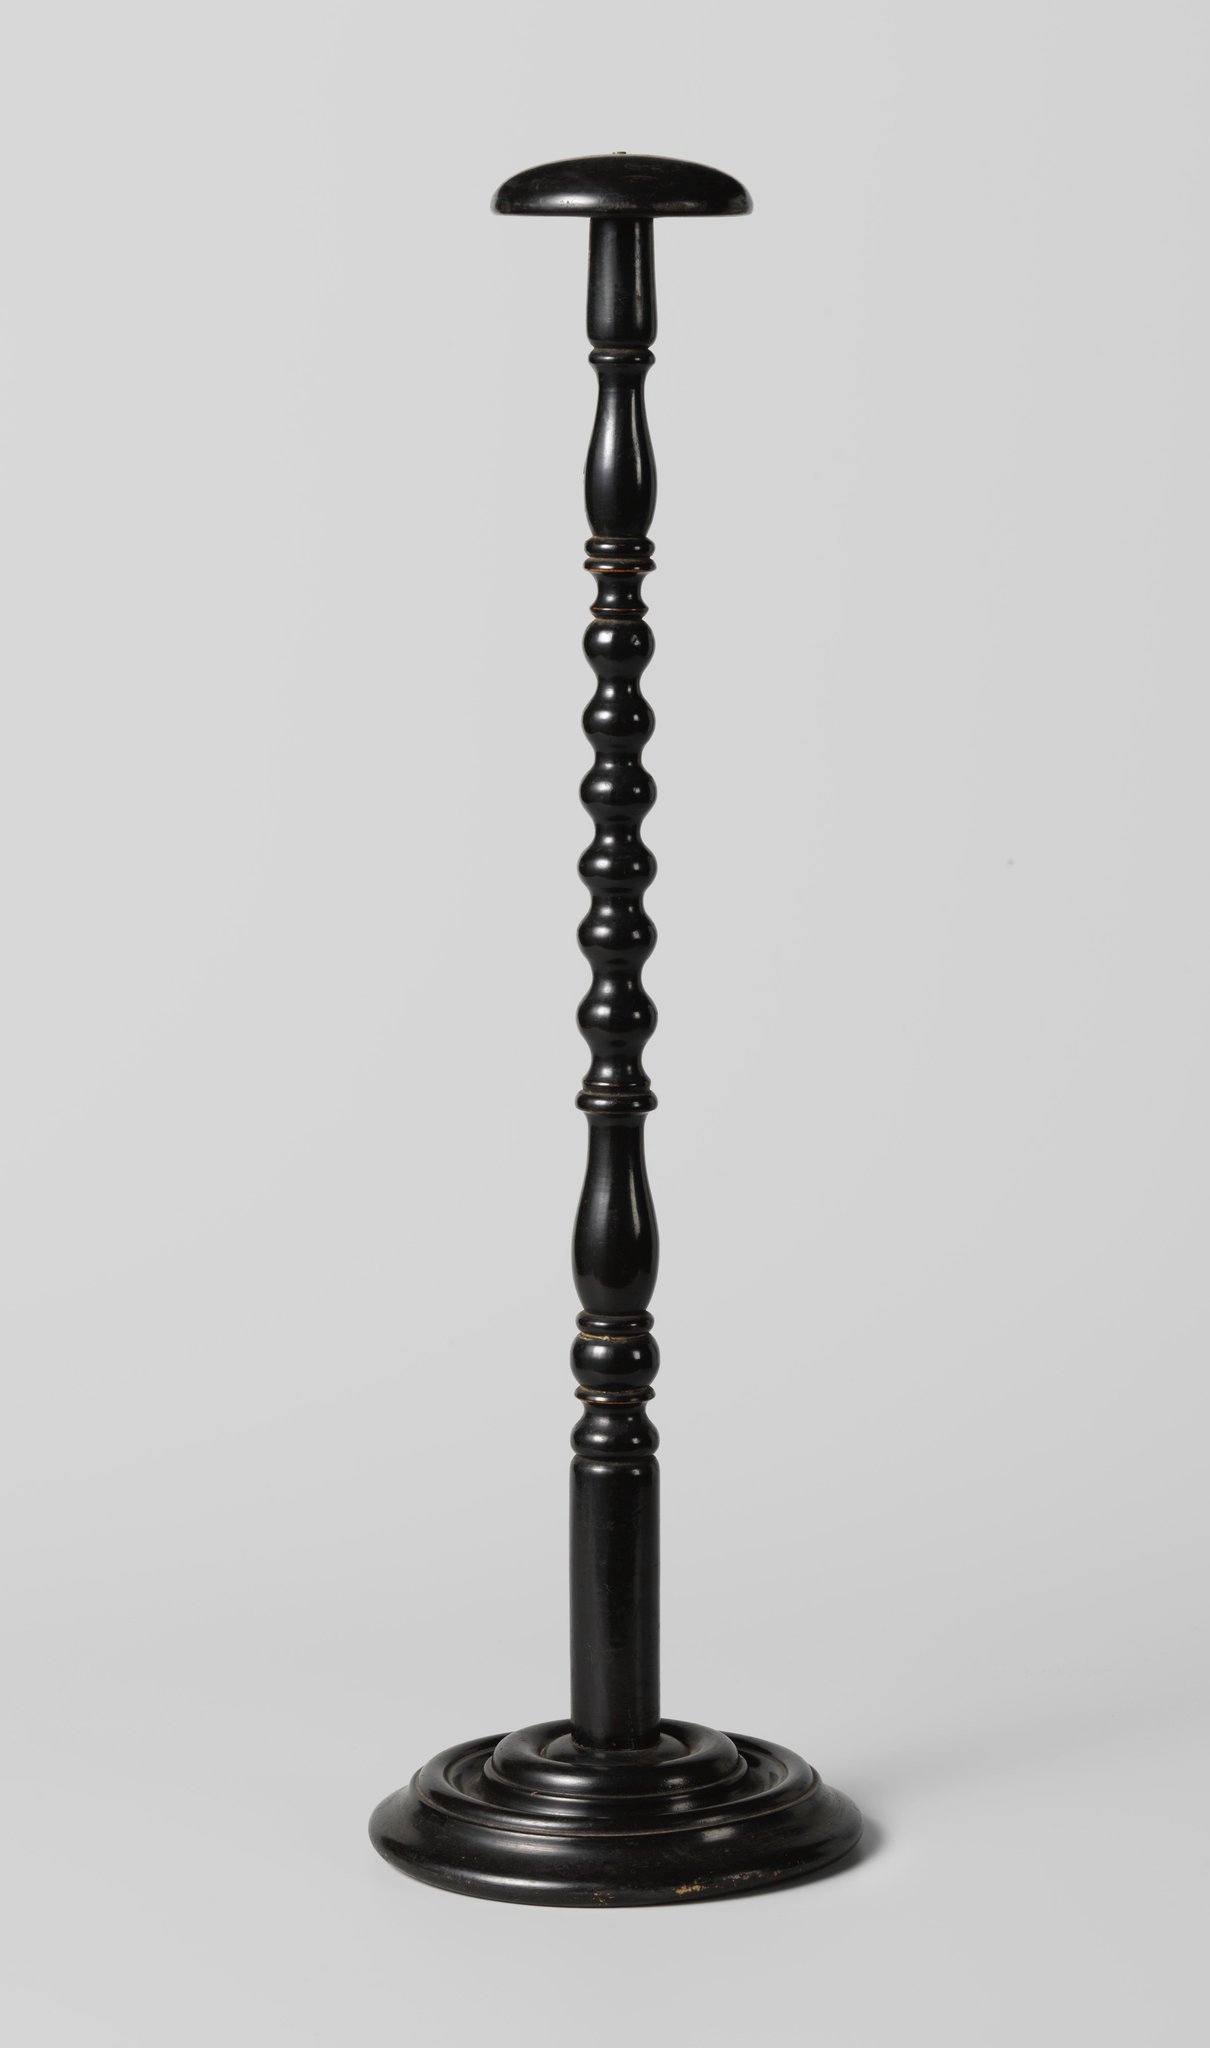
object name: stand support object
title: Standaard van het hoofdstel van het paard Alice dat op 12 augustus 1831 door de prins van Oranje werd bereden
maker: Anonymous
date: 1831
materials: wood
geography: netherlands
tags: alexander (prins der nederlanden, prins van oranje-nassau)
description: Houten zwart geverfde standaarden bestaande uit één lange en twee kortere delen met een breed rond voetstuk en een smaller rond topstuk waartussen een besneden gedraaide staak is bevestigd. Aan de standaard zit een papier met een lakzegel en een beschrijving van de herkomst van het object. Van het paard werd op bovengenoemde datum bij Bautersem door een kanonskogel het rechter voorbeen afgeschoten.